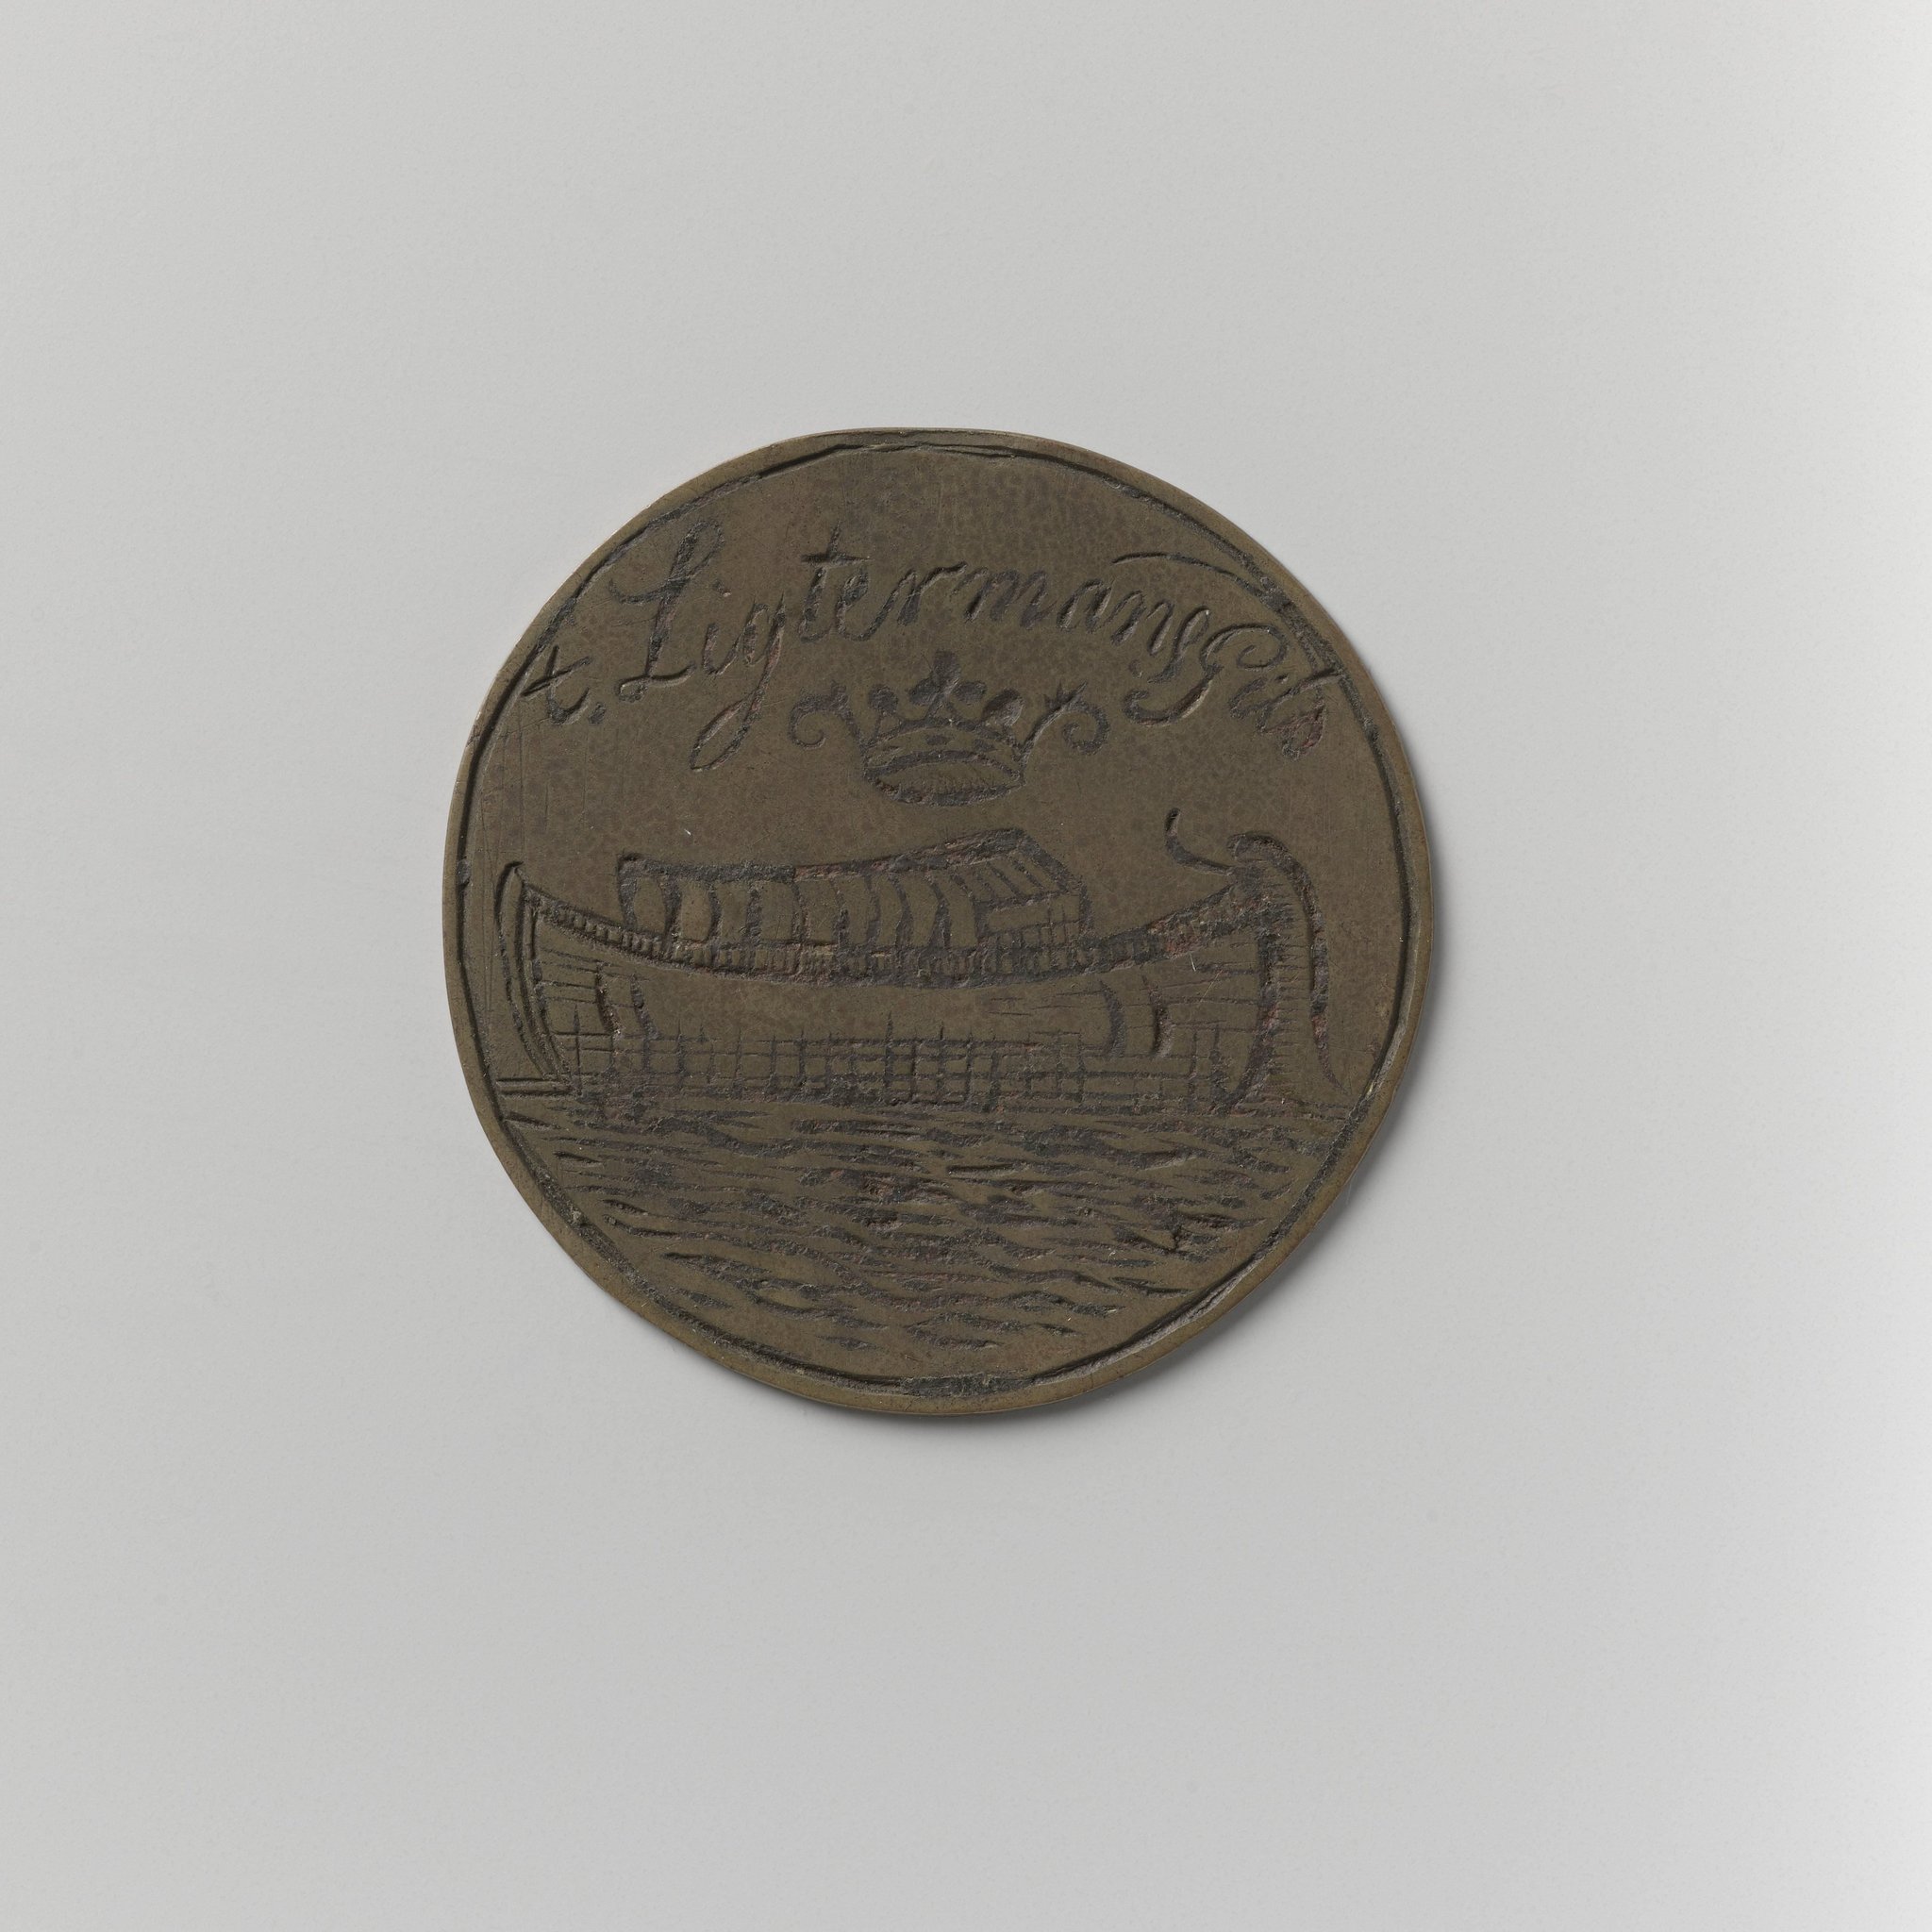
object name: medal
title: Korenlichtermansgilde van Amsterdam, gildepenning van Barend de Milde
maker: Anonymous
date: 1812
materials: brass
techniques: engraving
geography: amsterdam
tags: amsterdam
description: Messing penning. Voorzijde: gekroonde korenlichter onder opschrift. Keerzijde: opschrift